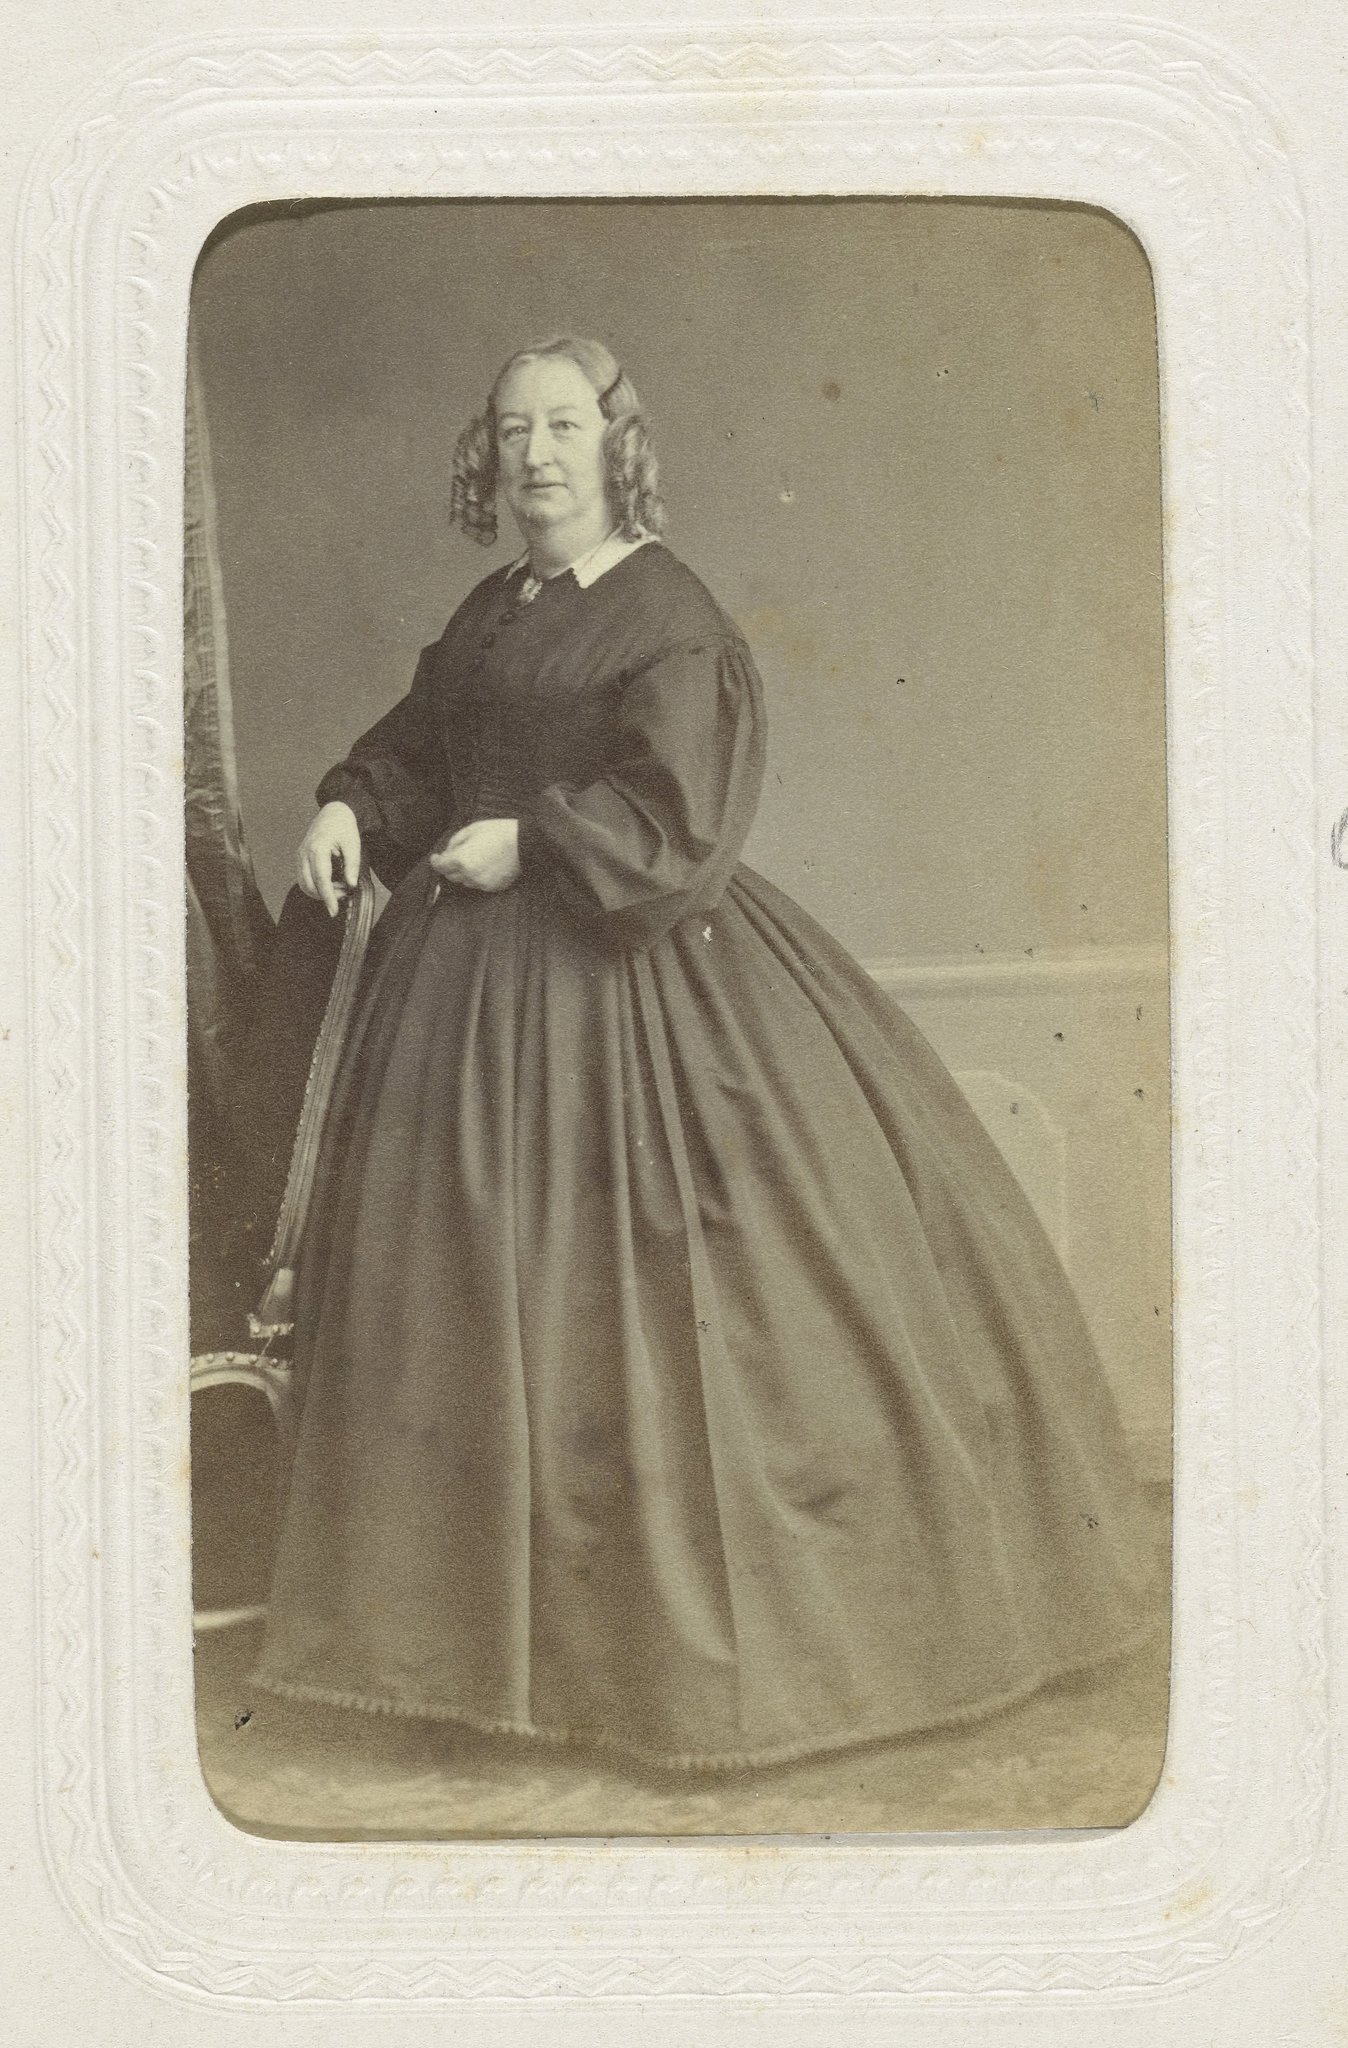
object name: carte de visite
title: Studioportret van een oudere vrouw in een lange zwarte jurk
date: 1863-1870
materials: cardboard, paper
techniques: albumen print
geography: brussels